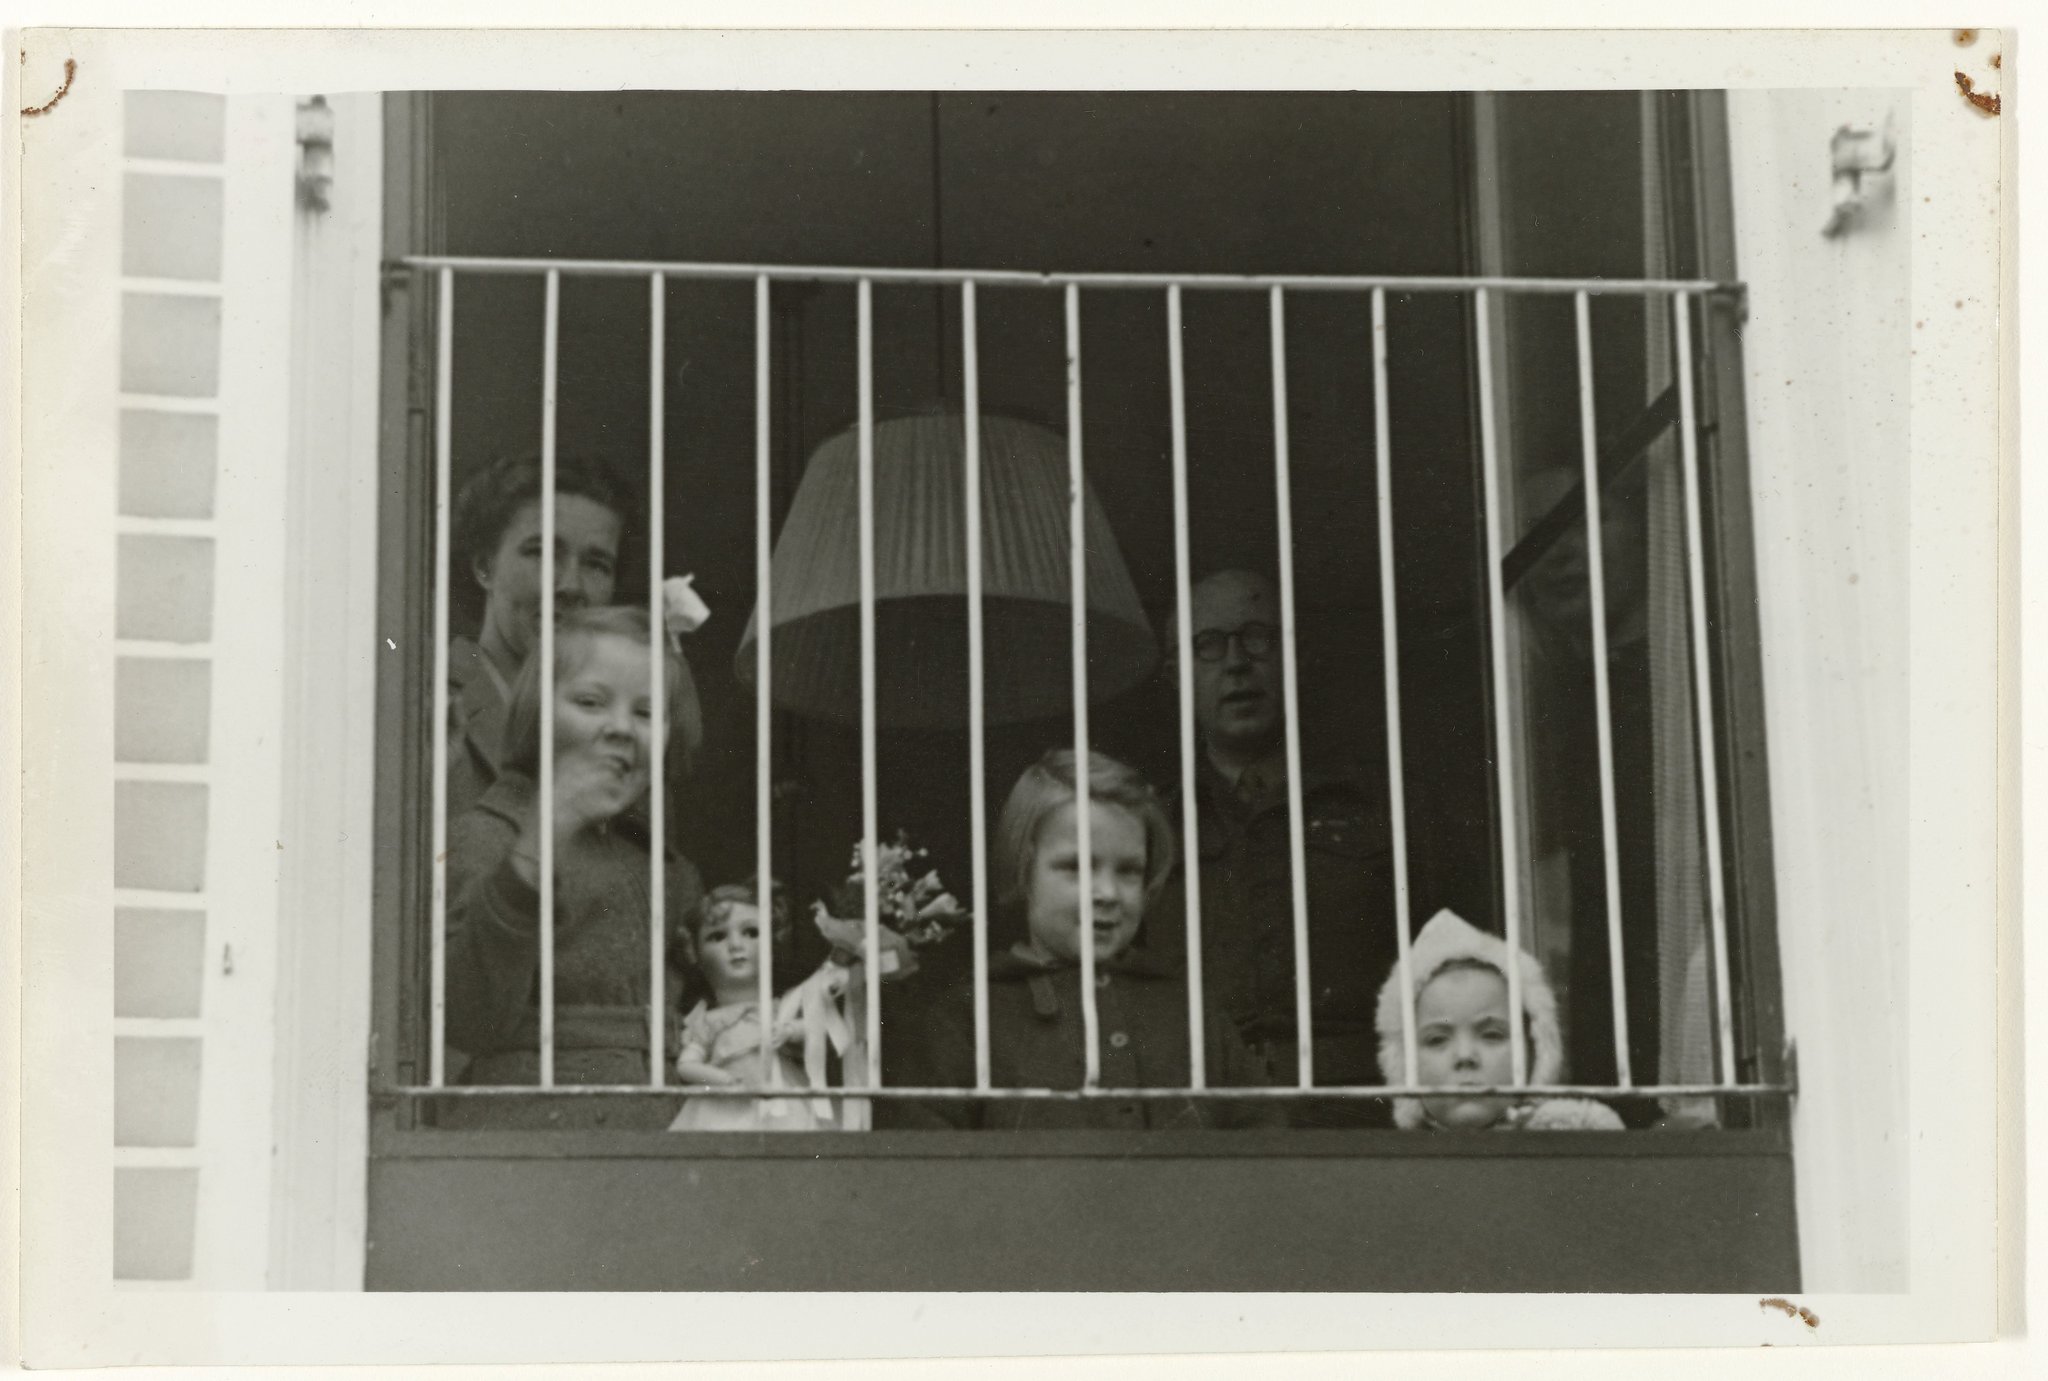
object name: photograph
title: Beatrix, Irene en Margriet voor het raam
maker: koos raucamp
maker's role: fotograaf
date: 1901-1946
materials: photographic support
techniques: photography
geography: soestdijk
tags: beatrix (koningin der nederlanden)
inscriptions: inscription, stamp: ‘COPYRIGHT / 'ANEFO' / ALGEMEEN NEDERLANDSCH FOTOBUREAU’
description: Beatrix, Irene en Margriet voor het raam van Paleis Soestdijk. Beatrix kon haar verjaardag op 31 januari niet feestelijk vieren omdat zij de mazelen had.